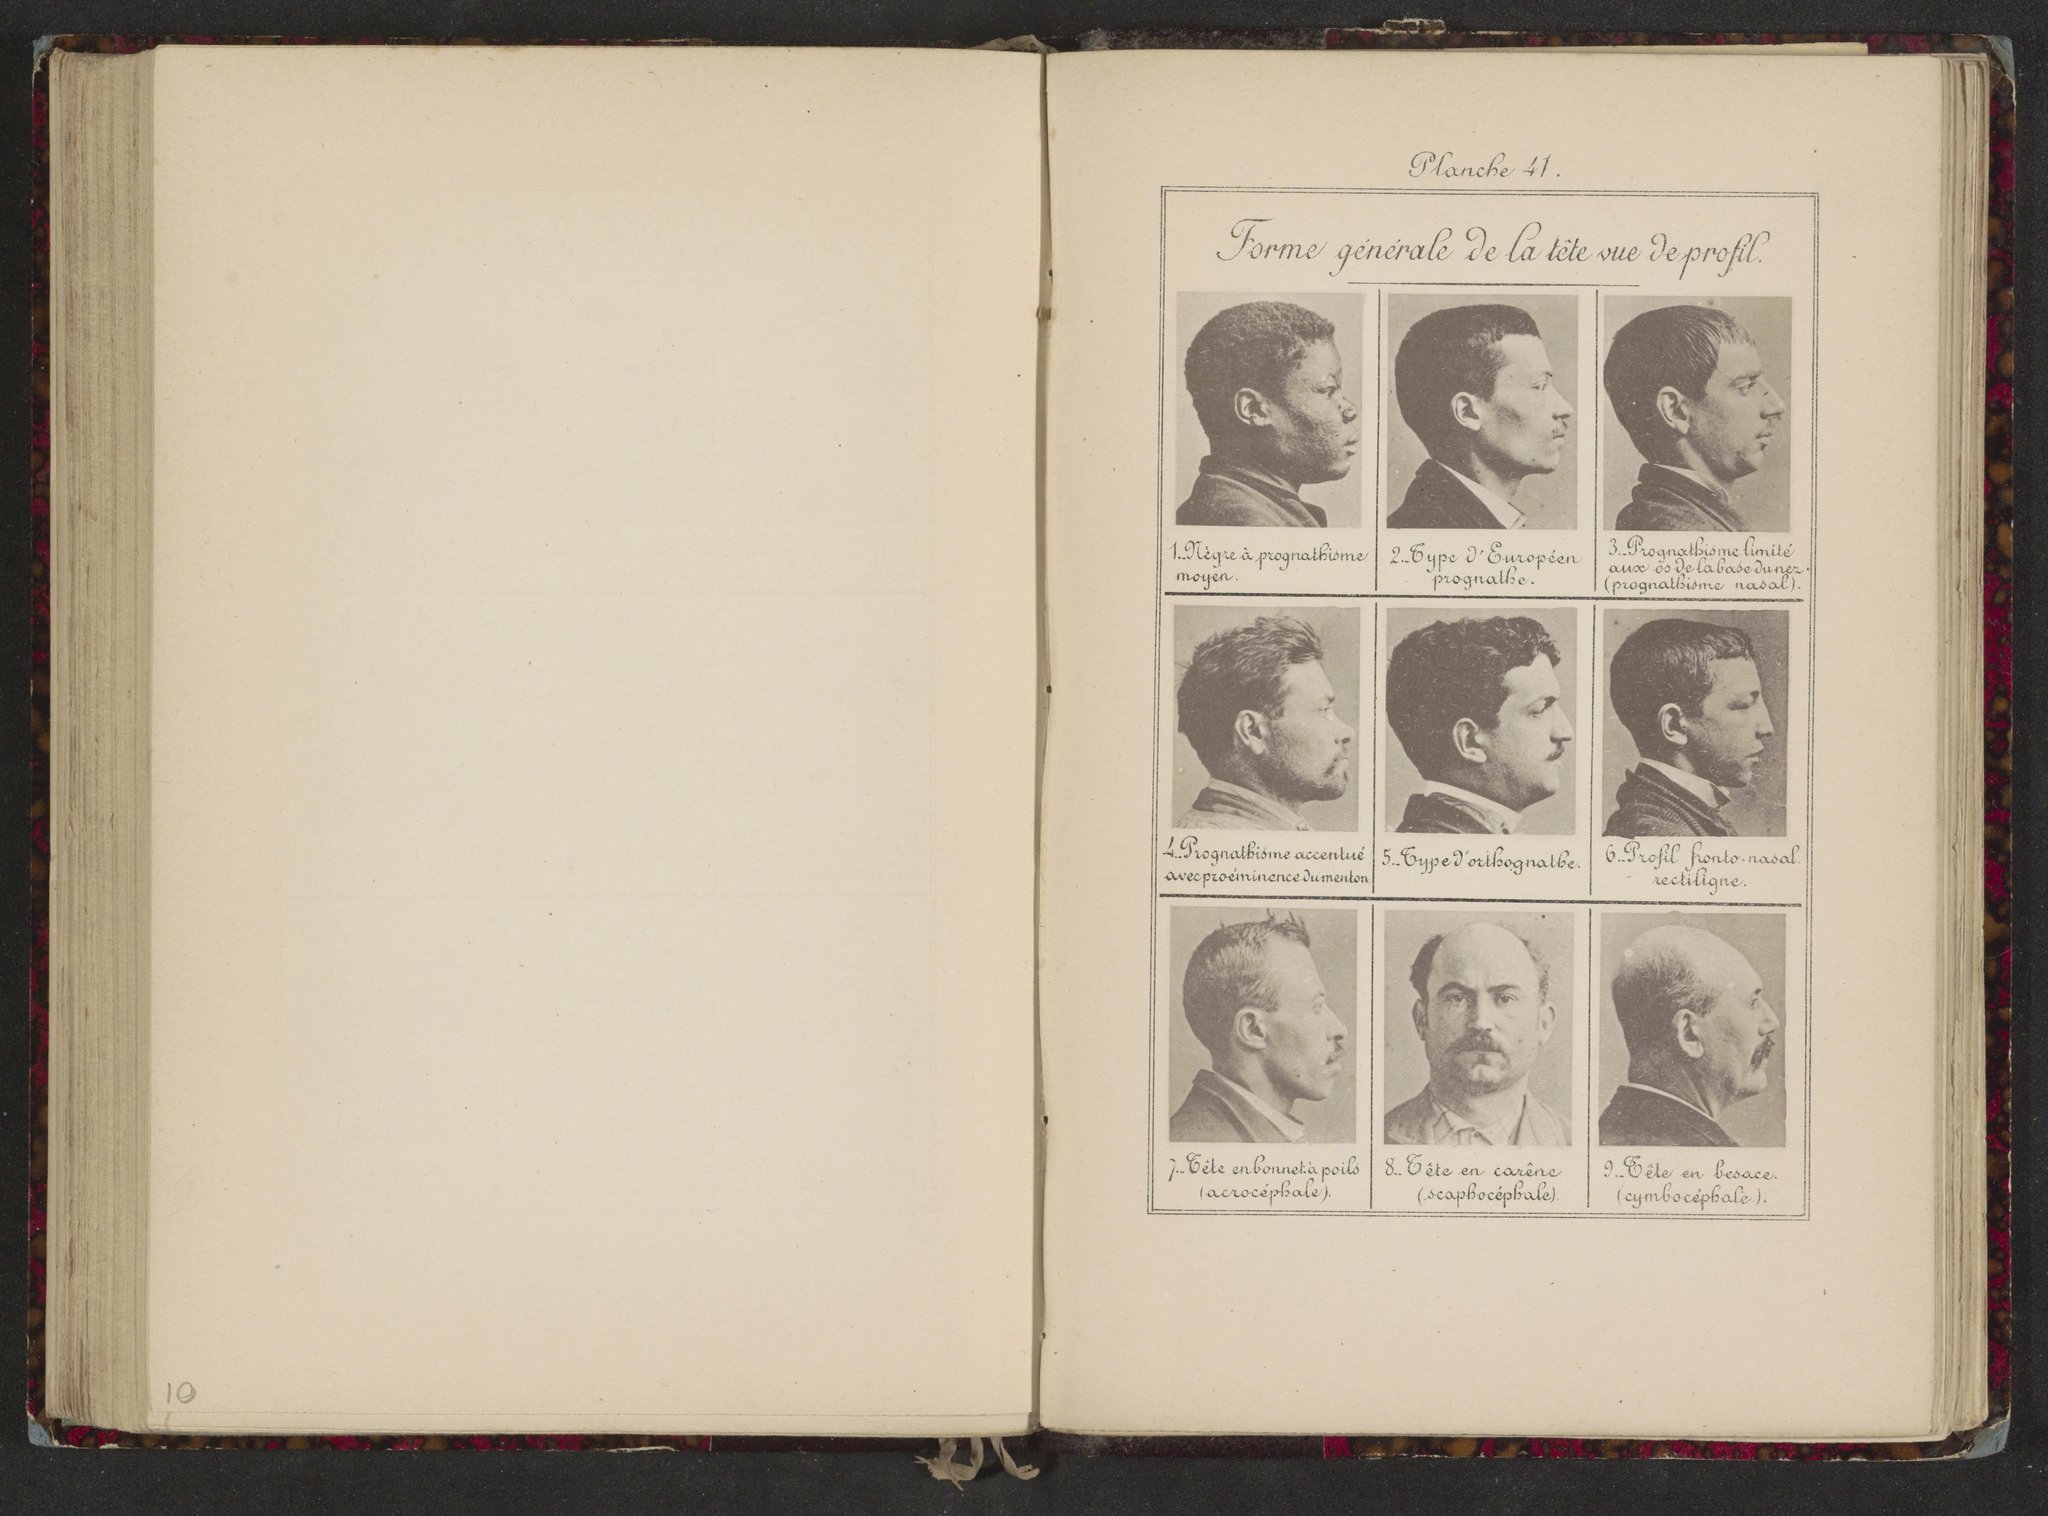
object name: page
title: Forme générale de la tête vue de profil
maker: Anonymous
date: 1880-1893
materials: paper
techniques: photograph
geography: france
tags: head (human) (+ front view), head (human) (+ sideview, profile), france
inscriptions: number: ‘Planche 41.’, inscription: ‘Négre à prognathisme moyen. (...) Tête en besace (cymbocéphale).’, number: ‘1. (...) 9.’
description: Acht in zijaanzicht, nummer 8 in vooraanzicht.